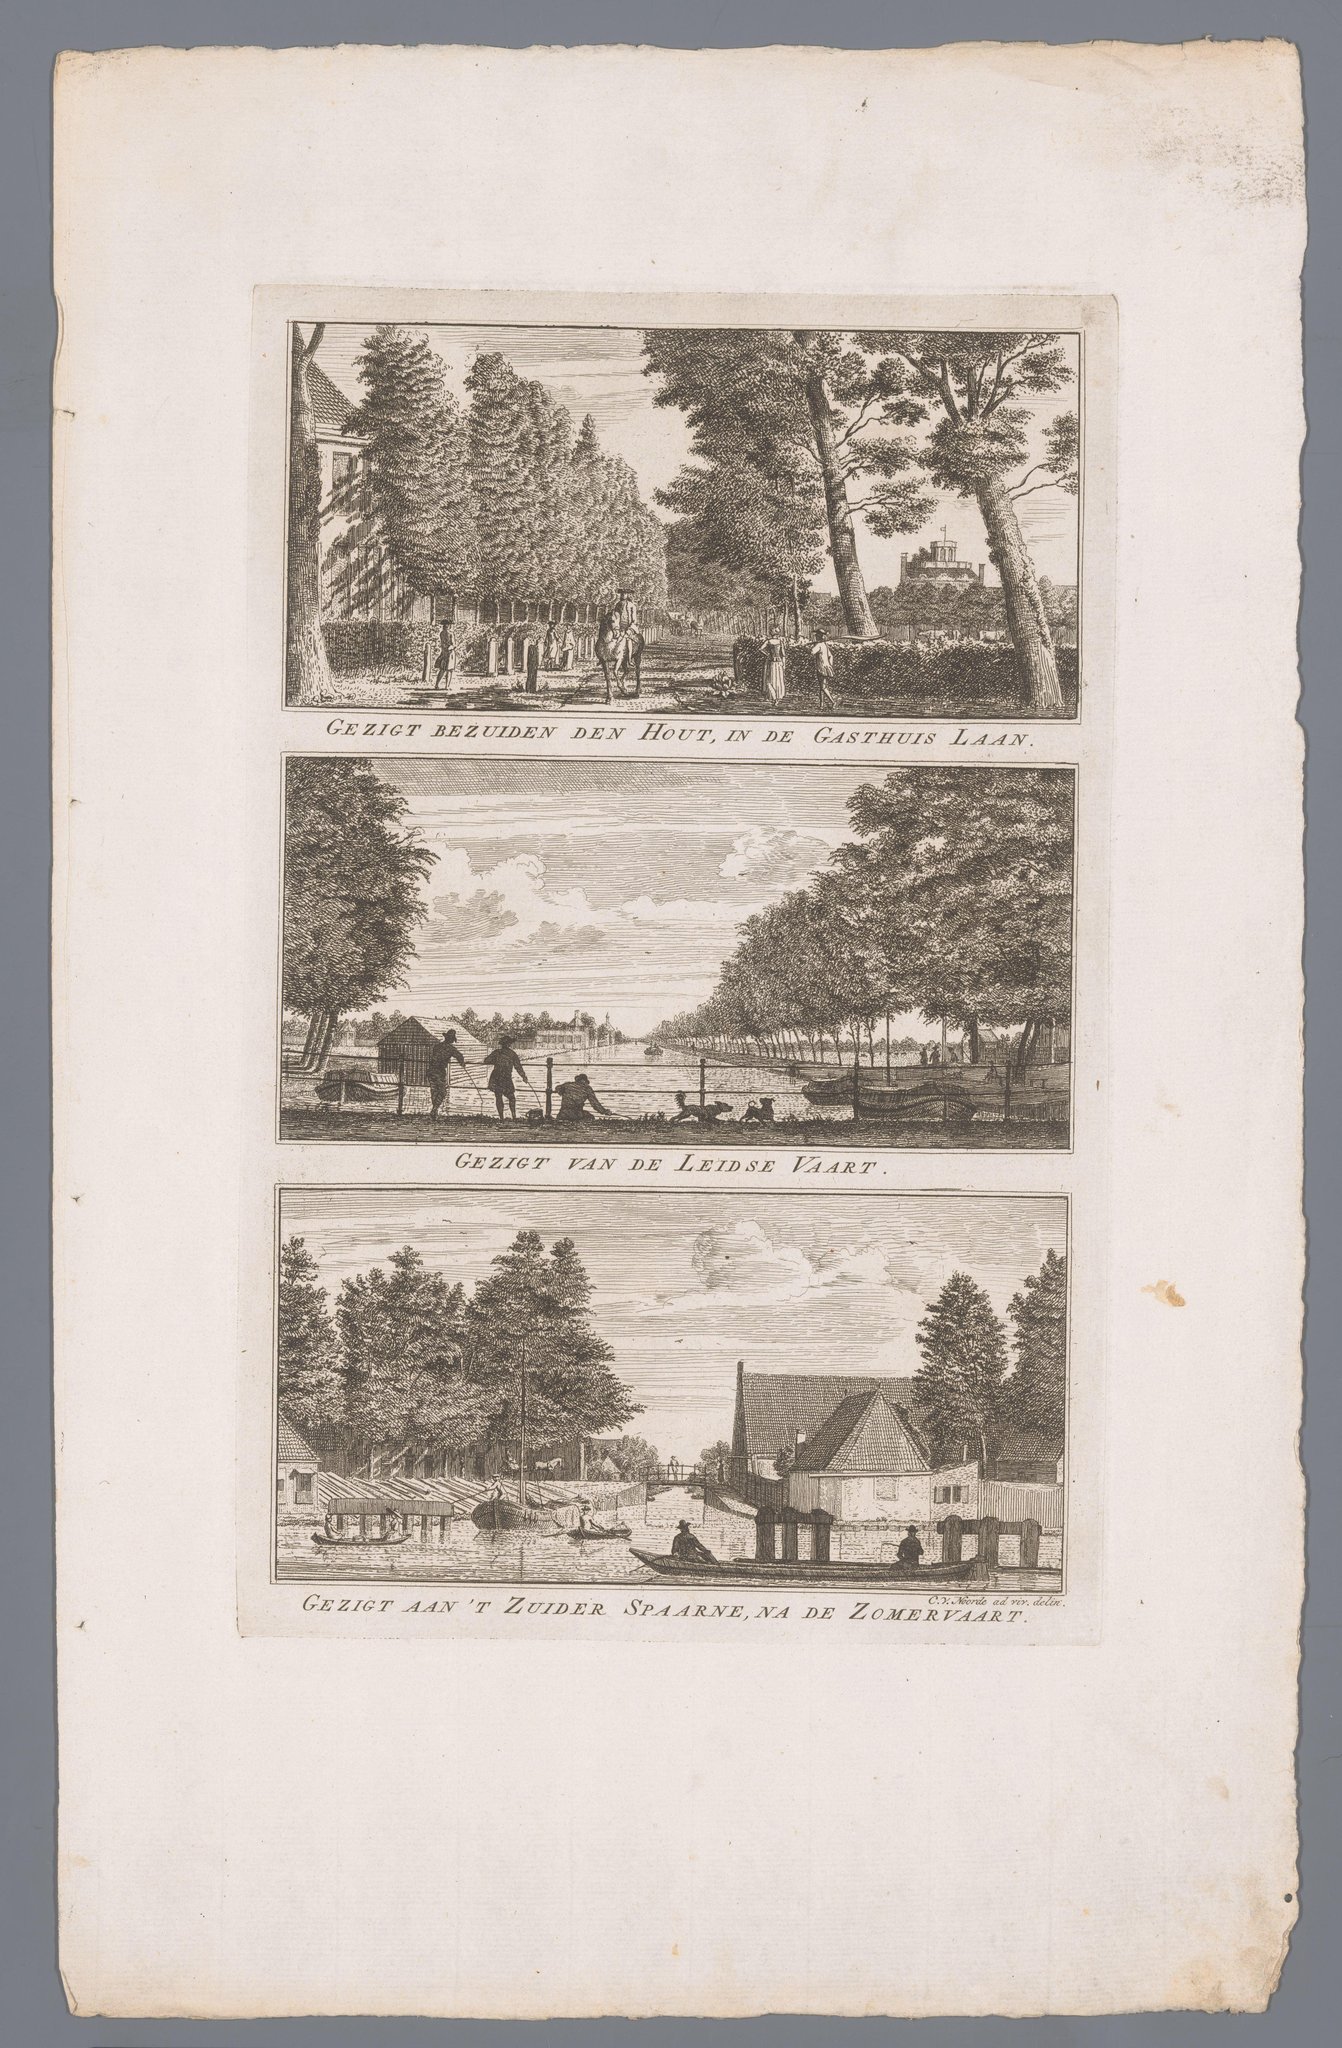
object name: print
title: Gezichten op Gasthuislaan, Leidsevaart en Zuider Spaarne te Haarlem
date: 1763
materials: paper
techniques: etching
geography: haarlem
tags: river, canal, lane, alley, haarlem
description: Drie voorstellingen. Boven: De Gasthuislaan te Haarlem ten zuiden van de Haarlemmerhout. Midden: Gezicht op de Leidsevaart te Haarlem. Onder: Gezicht op het Zuider Spaarne bij de Zomervaart te Haarlem.